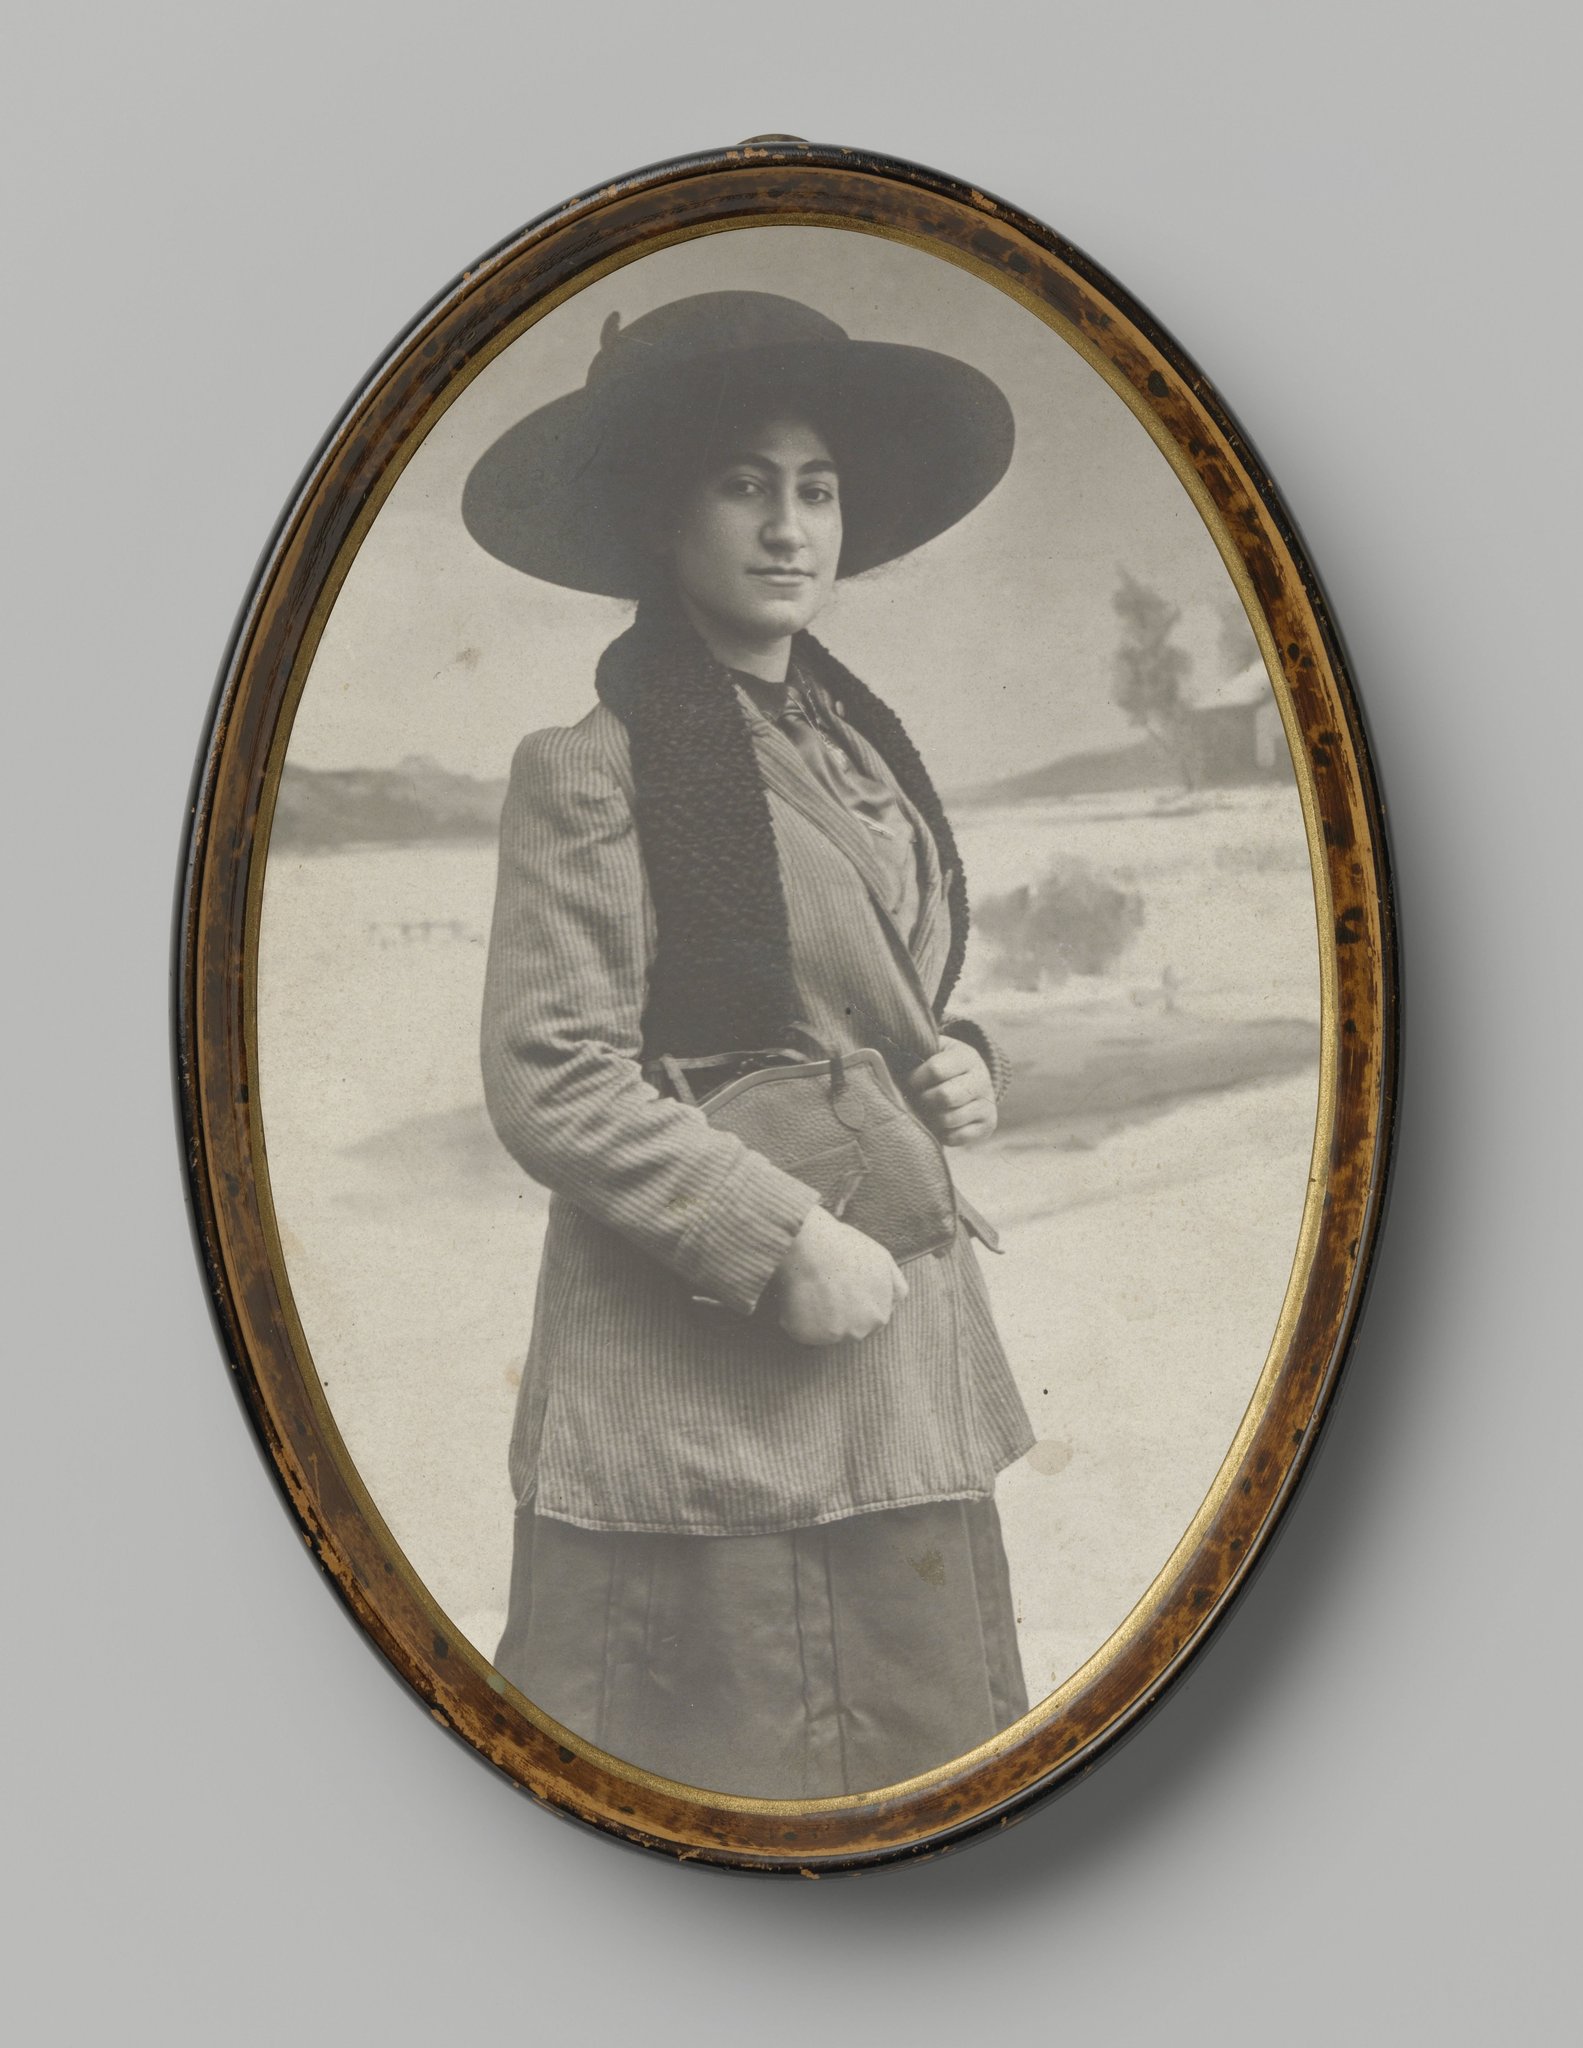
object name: frame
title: Photo Frames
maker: Anonymous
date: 1880-1900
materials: paper, glass, wood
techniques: gelatin silver print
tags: bag, head-gear: hat, anonymous historical person portrayed - bb - woman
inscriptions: inscription: ‘UIT HET ATELIER/ WILLIAM/ PRINSENGRACHT 106/ b/d UTRECHTSESTRAAT’